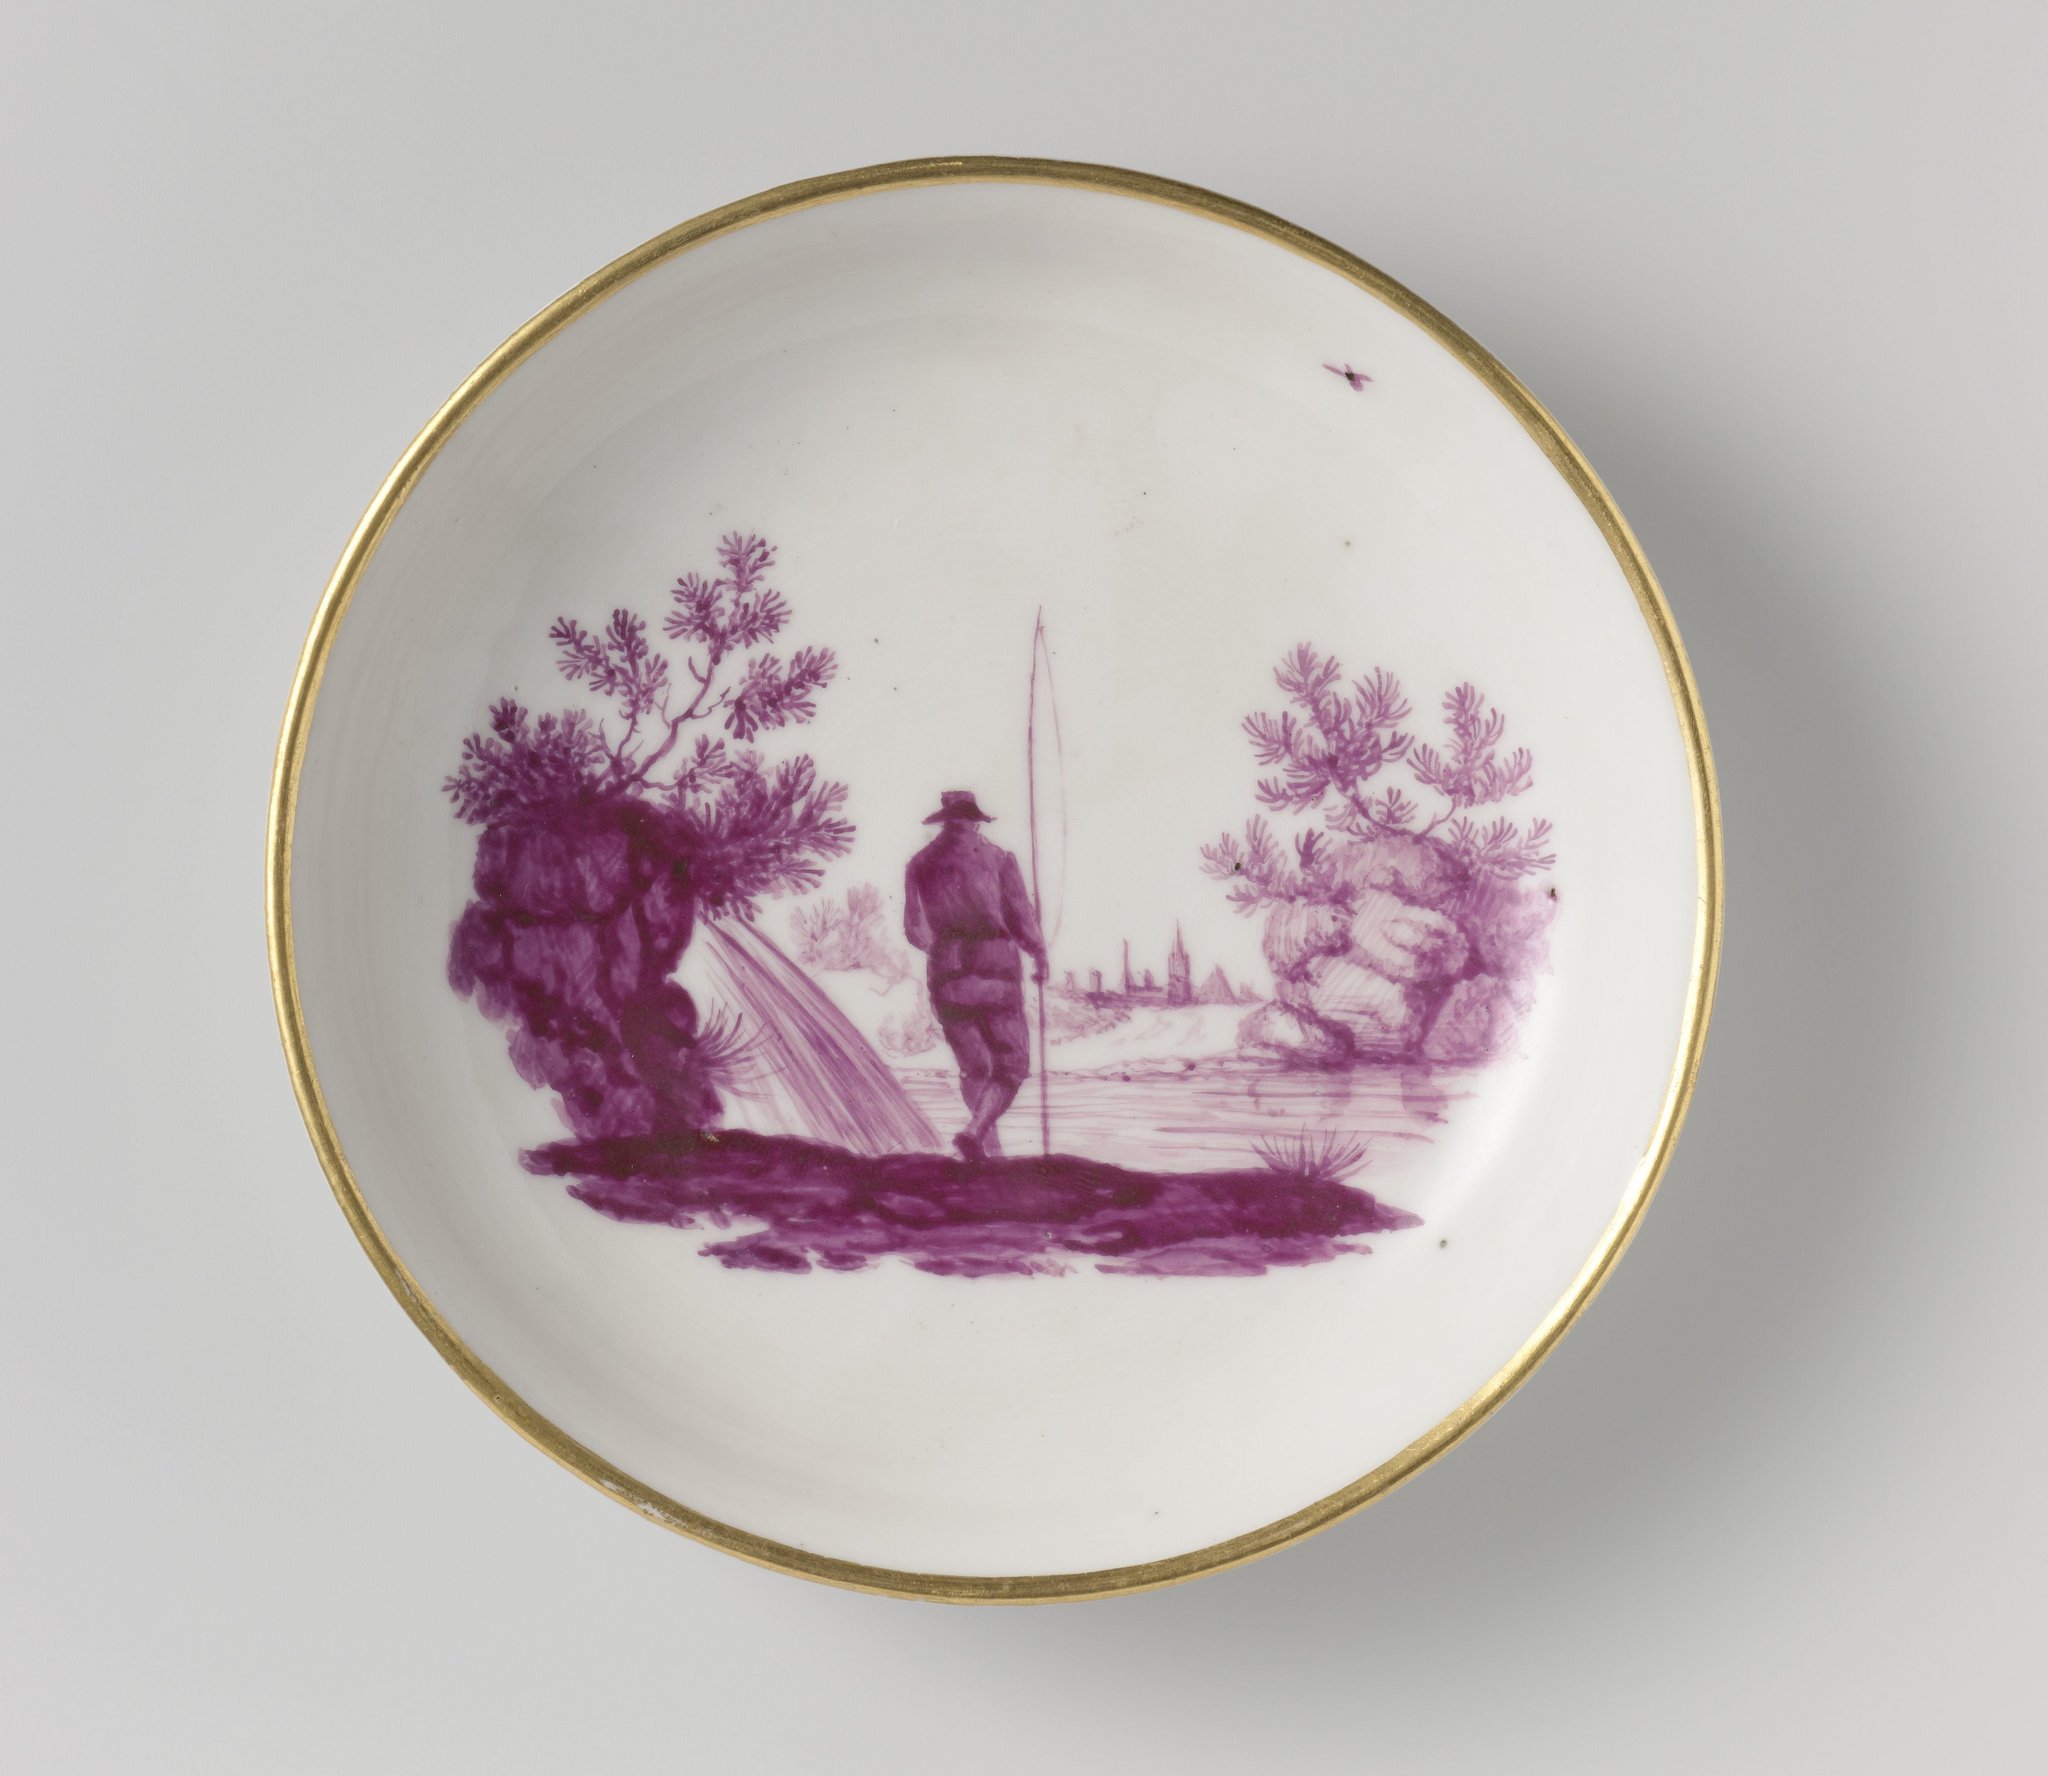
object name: platter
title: Schotel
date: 1775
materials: porcelain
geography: loosdrecht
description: Schotel van porselein. Onderdeel van een serie van twaafl stuks. Beschilderd met figuren in een landschap in bietenrood en gouden biezen.